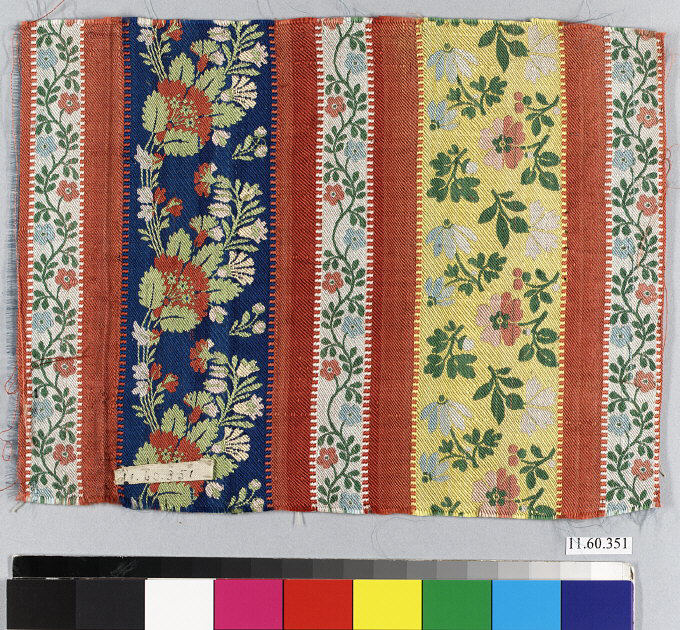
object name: fragment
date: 1801-1900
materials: silk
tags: flowers,leaves